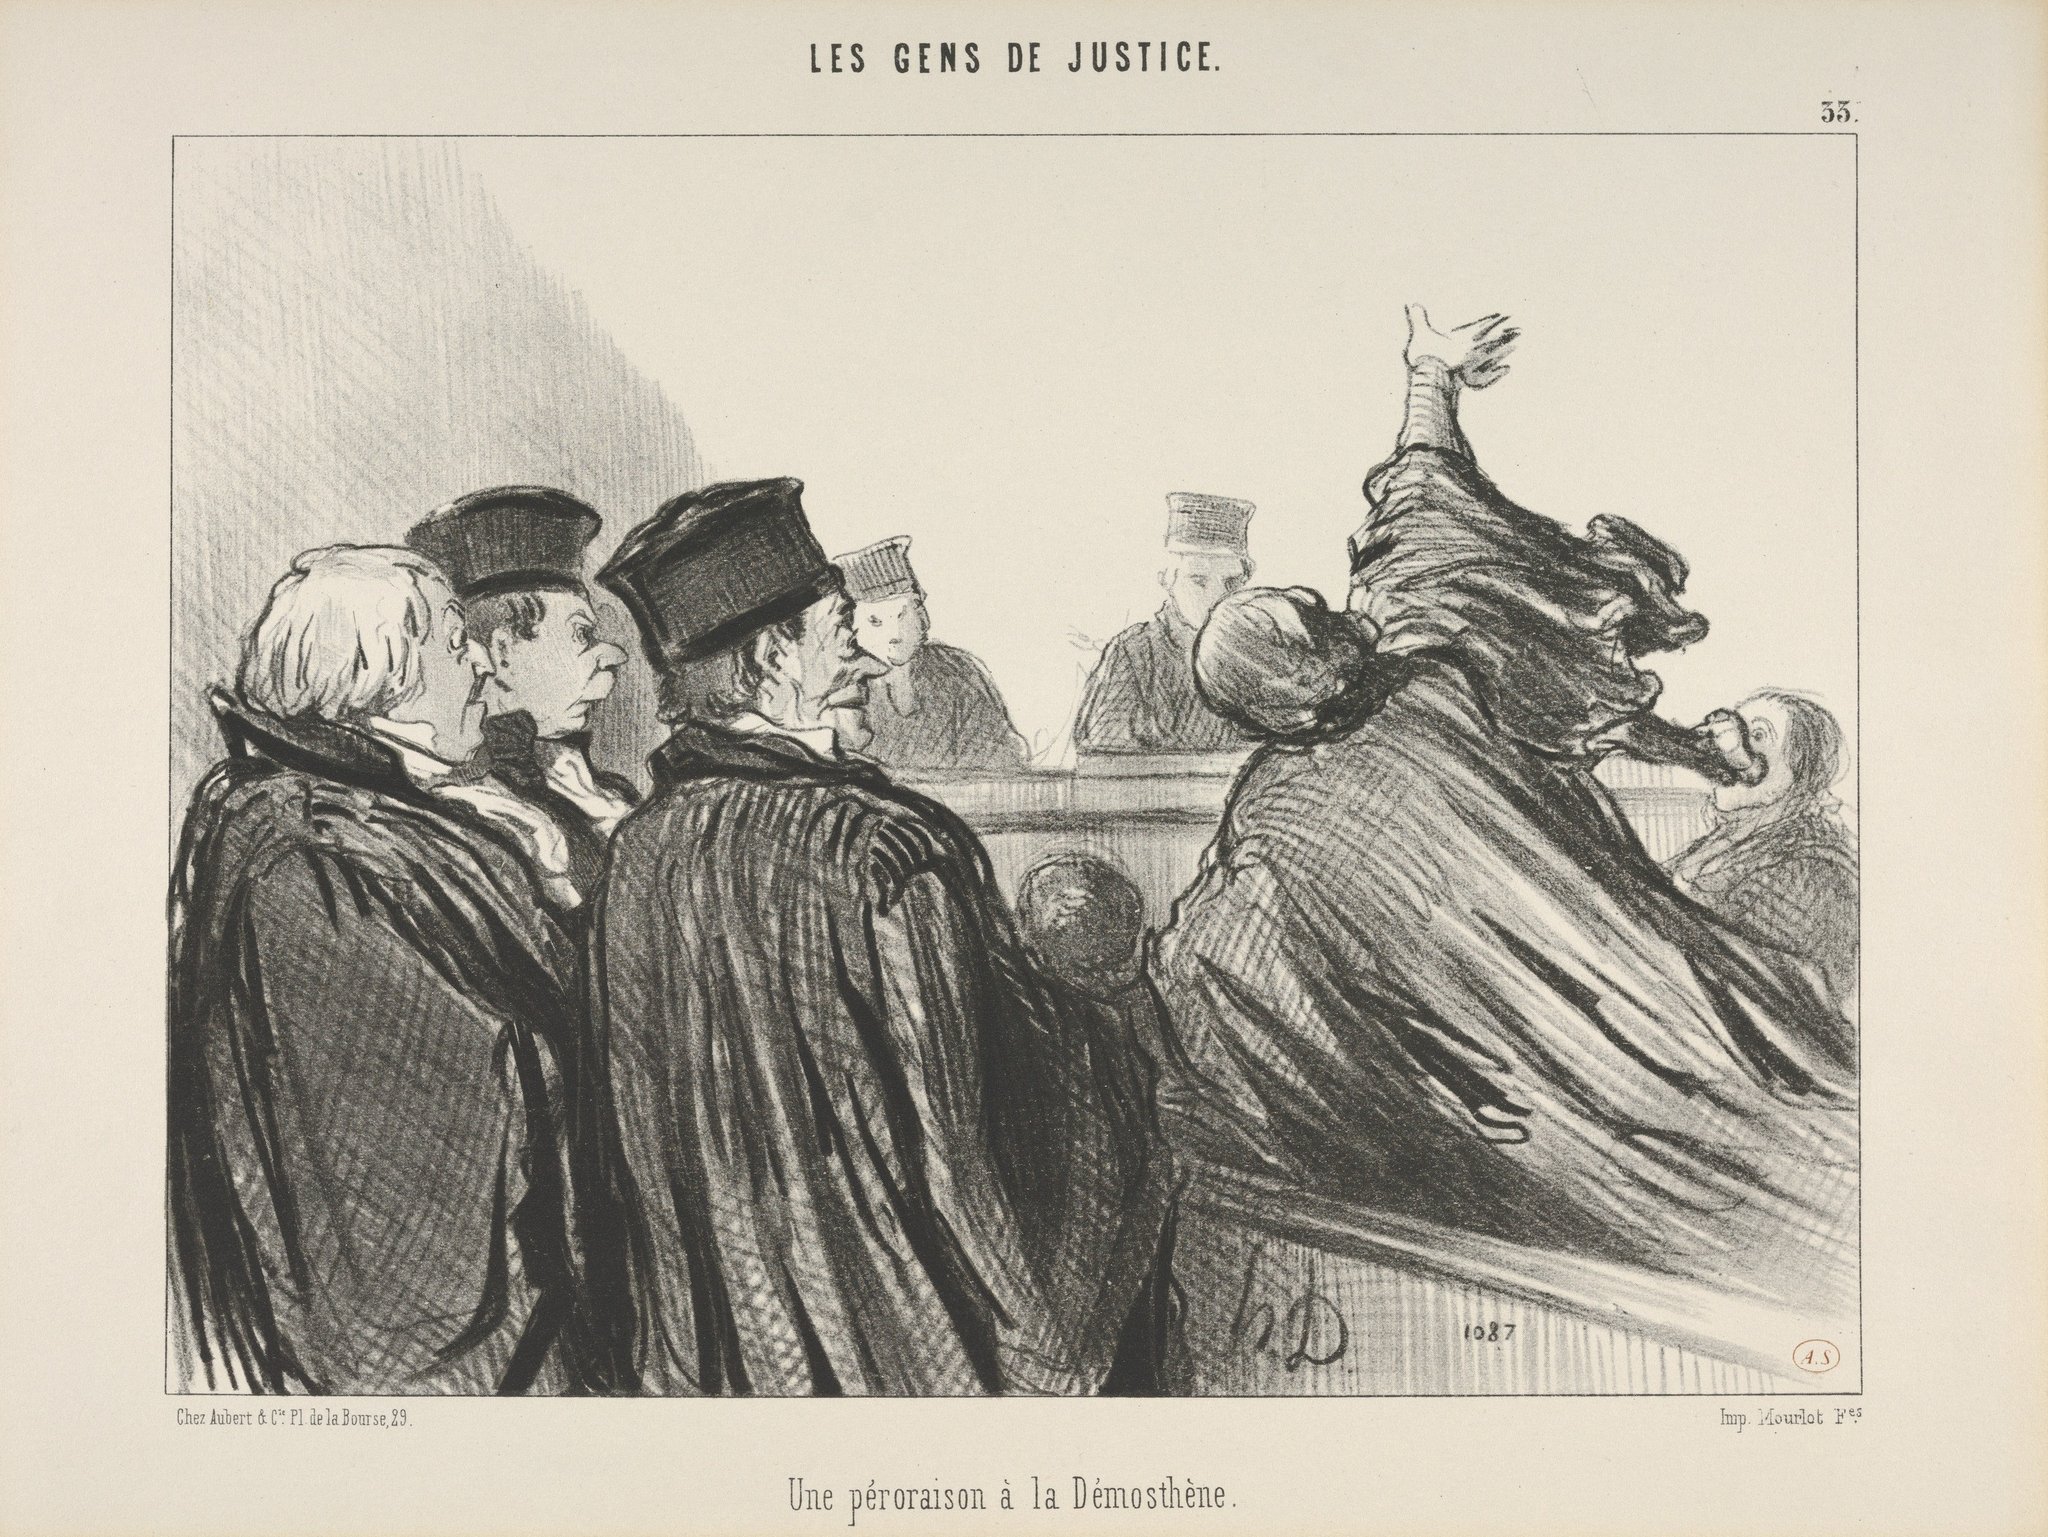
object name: print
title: "Une péroraison à la Démosthène," plate 33 from Les Gens de Justice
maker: honoré daumier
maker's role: artist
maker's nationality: french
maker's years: 1808-1879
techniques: lithograph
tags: men